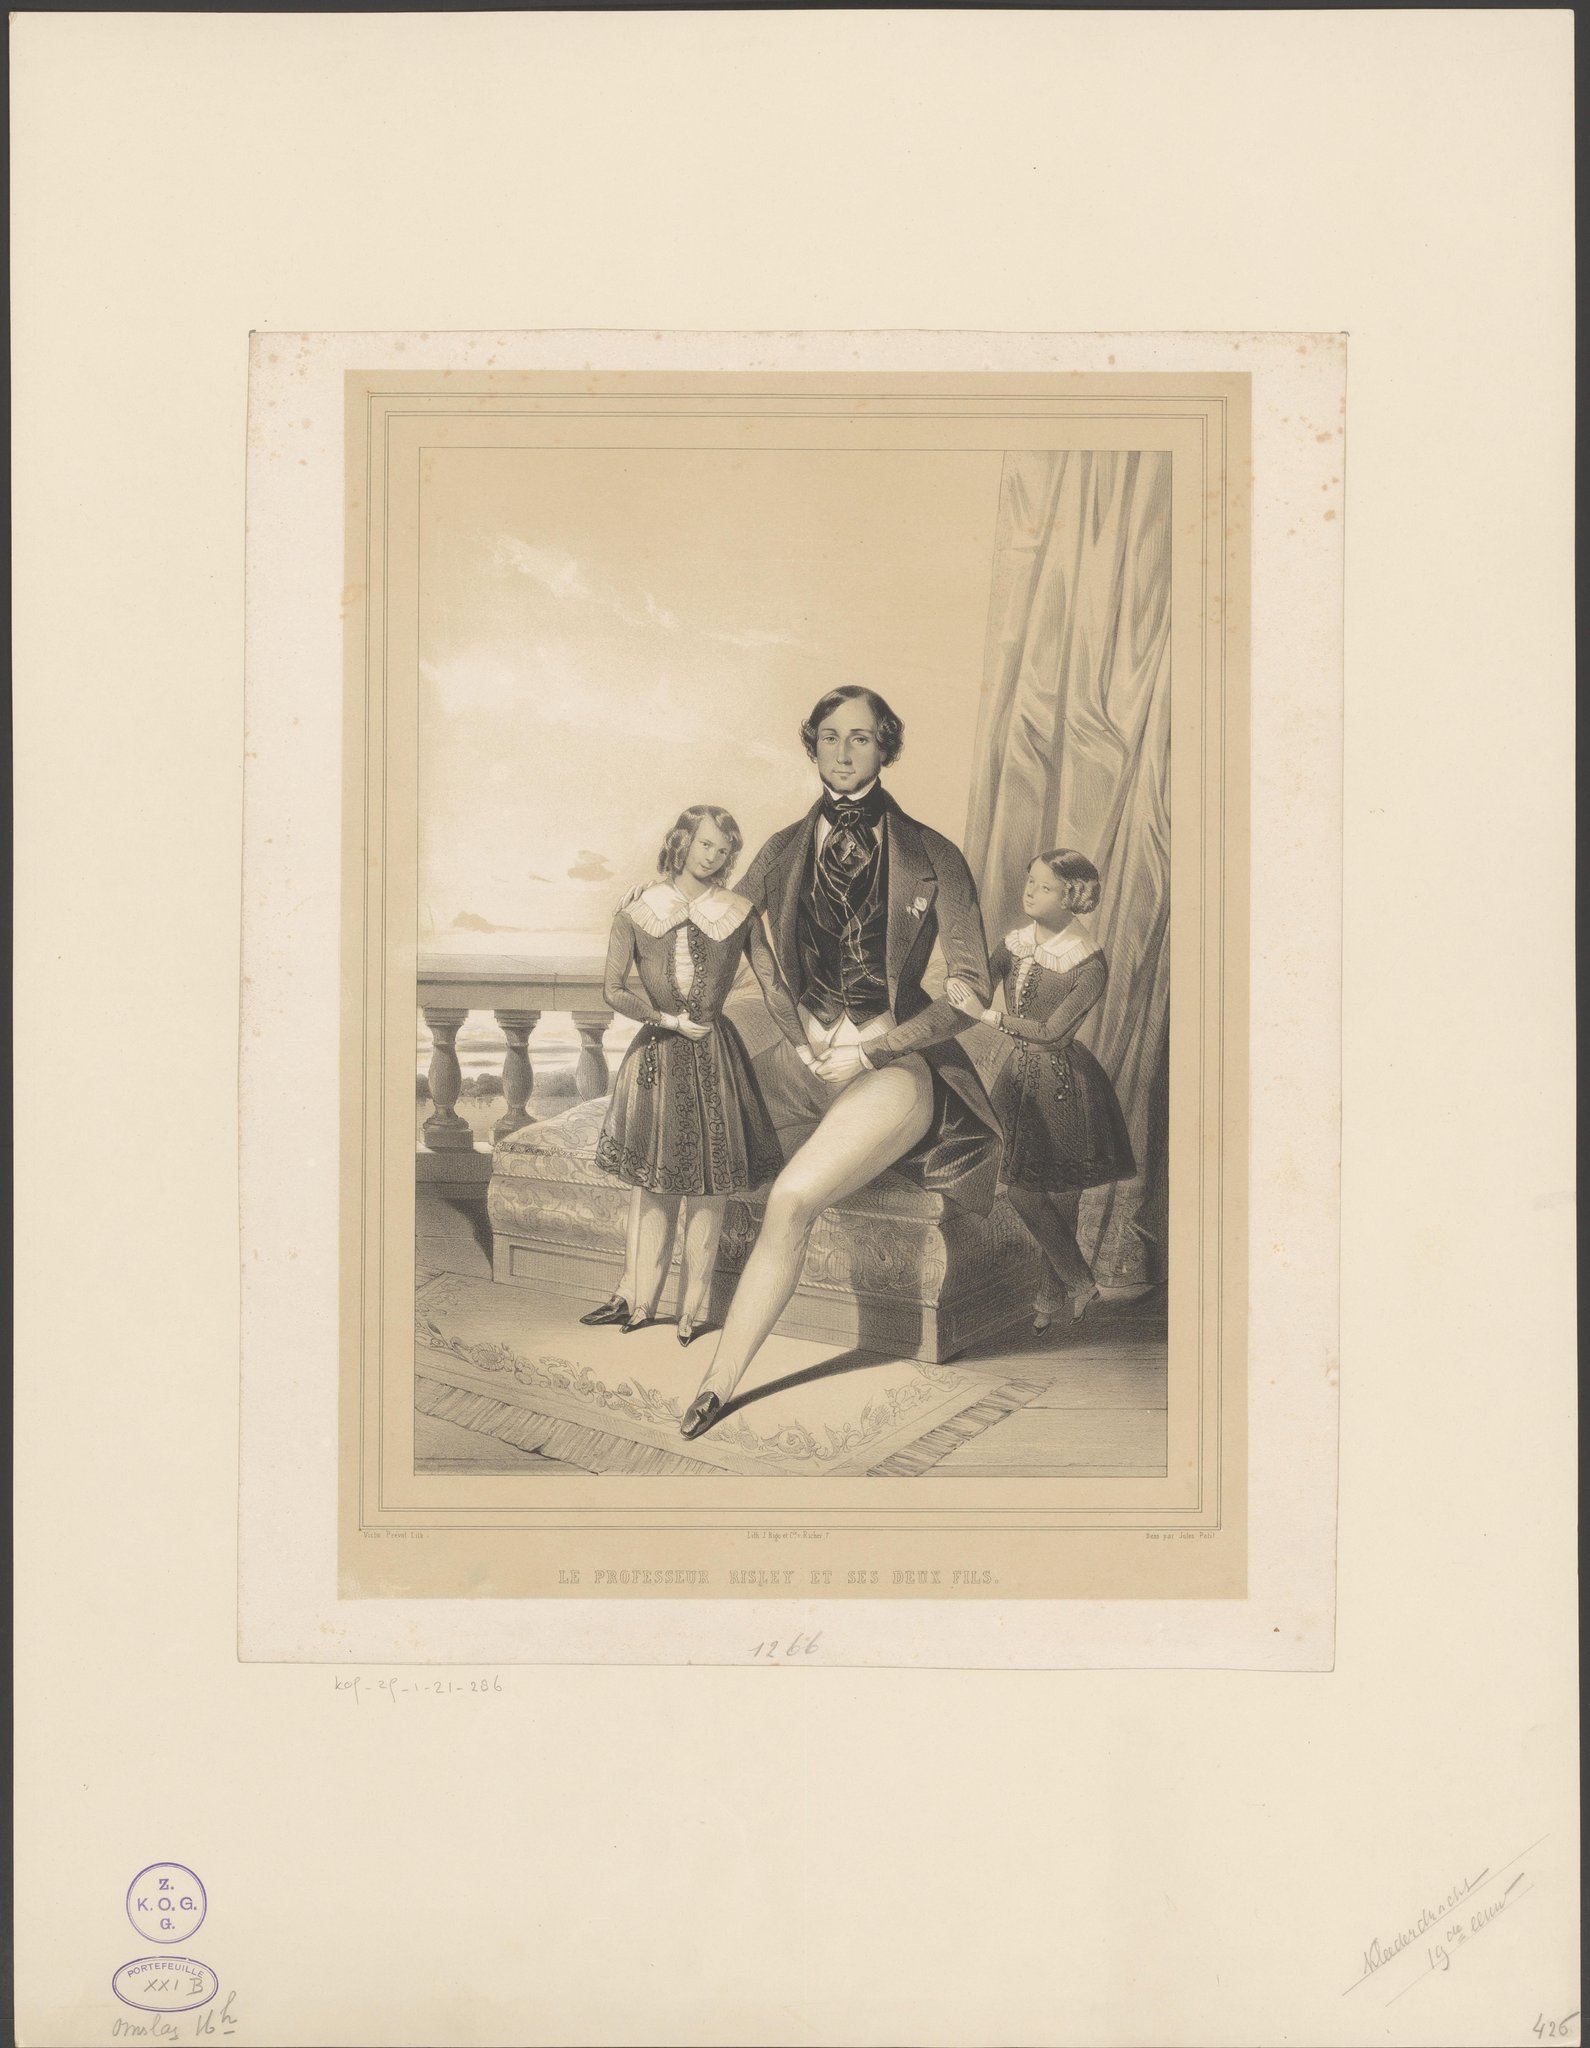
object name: print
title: Le professeur Risley et ses deux fils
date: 1844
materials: paper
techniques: tone lithography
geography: paris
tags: historical persons, acrobat ~ circus, father with son(s) (father-love), sitting on an elevation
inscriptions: collector's mark: Lugt 1641, stamp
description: Onderwerpsrubrieken binnen de Atlas Zeden en Gewoonten: Zeden en Gewoonten in Engeren Zin, De Kleeding, Kleederdrachten (tijdvakken), Het midden der 19de eeuw. Mannen en vrouwen.